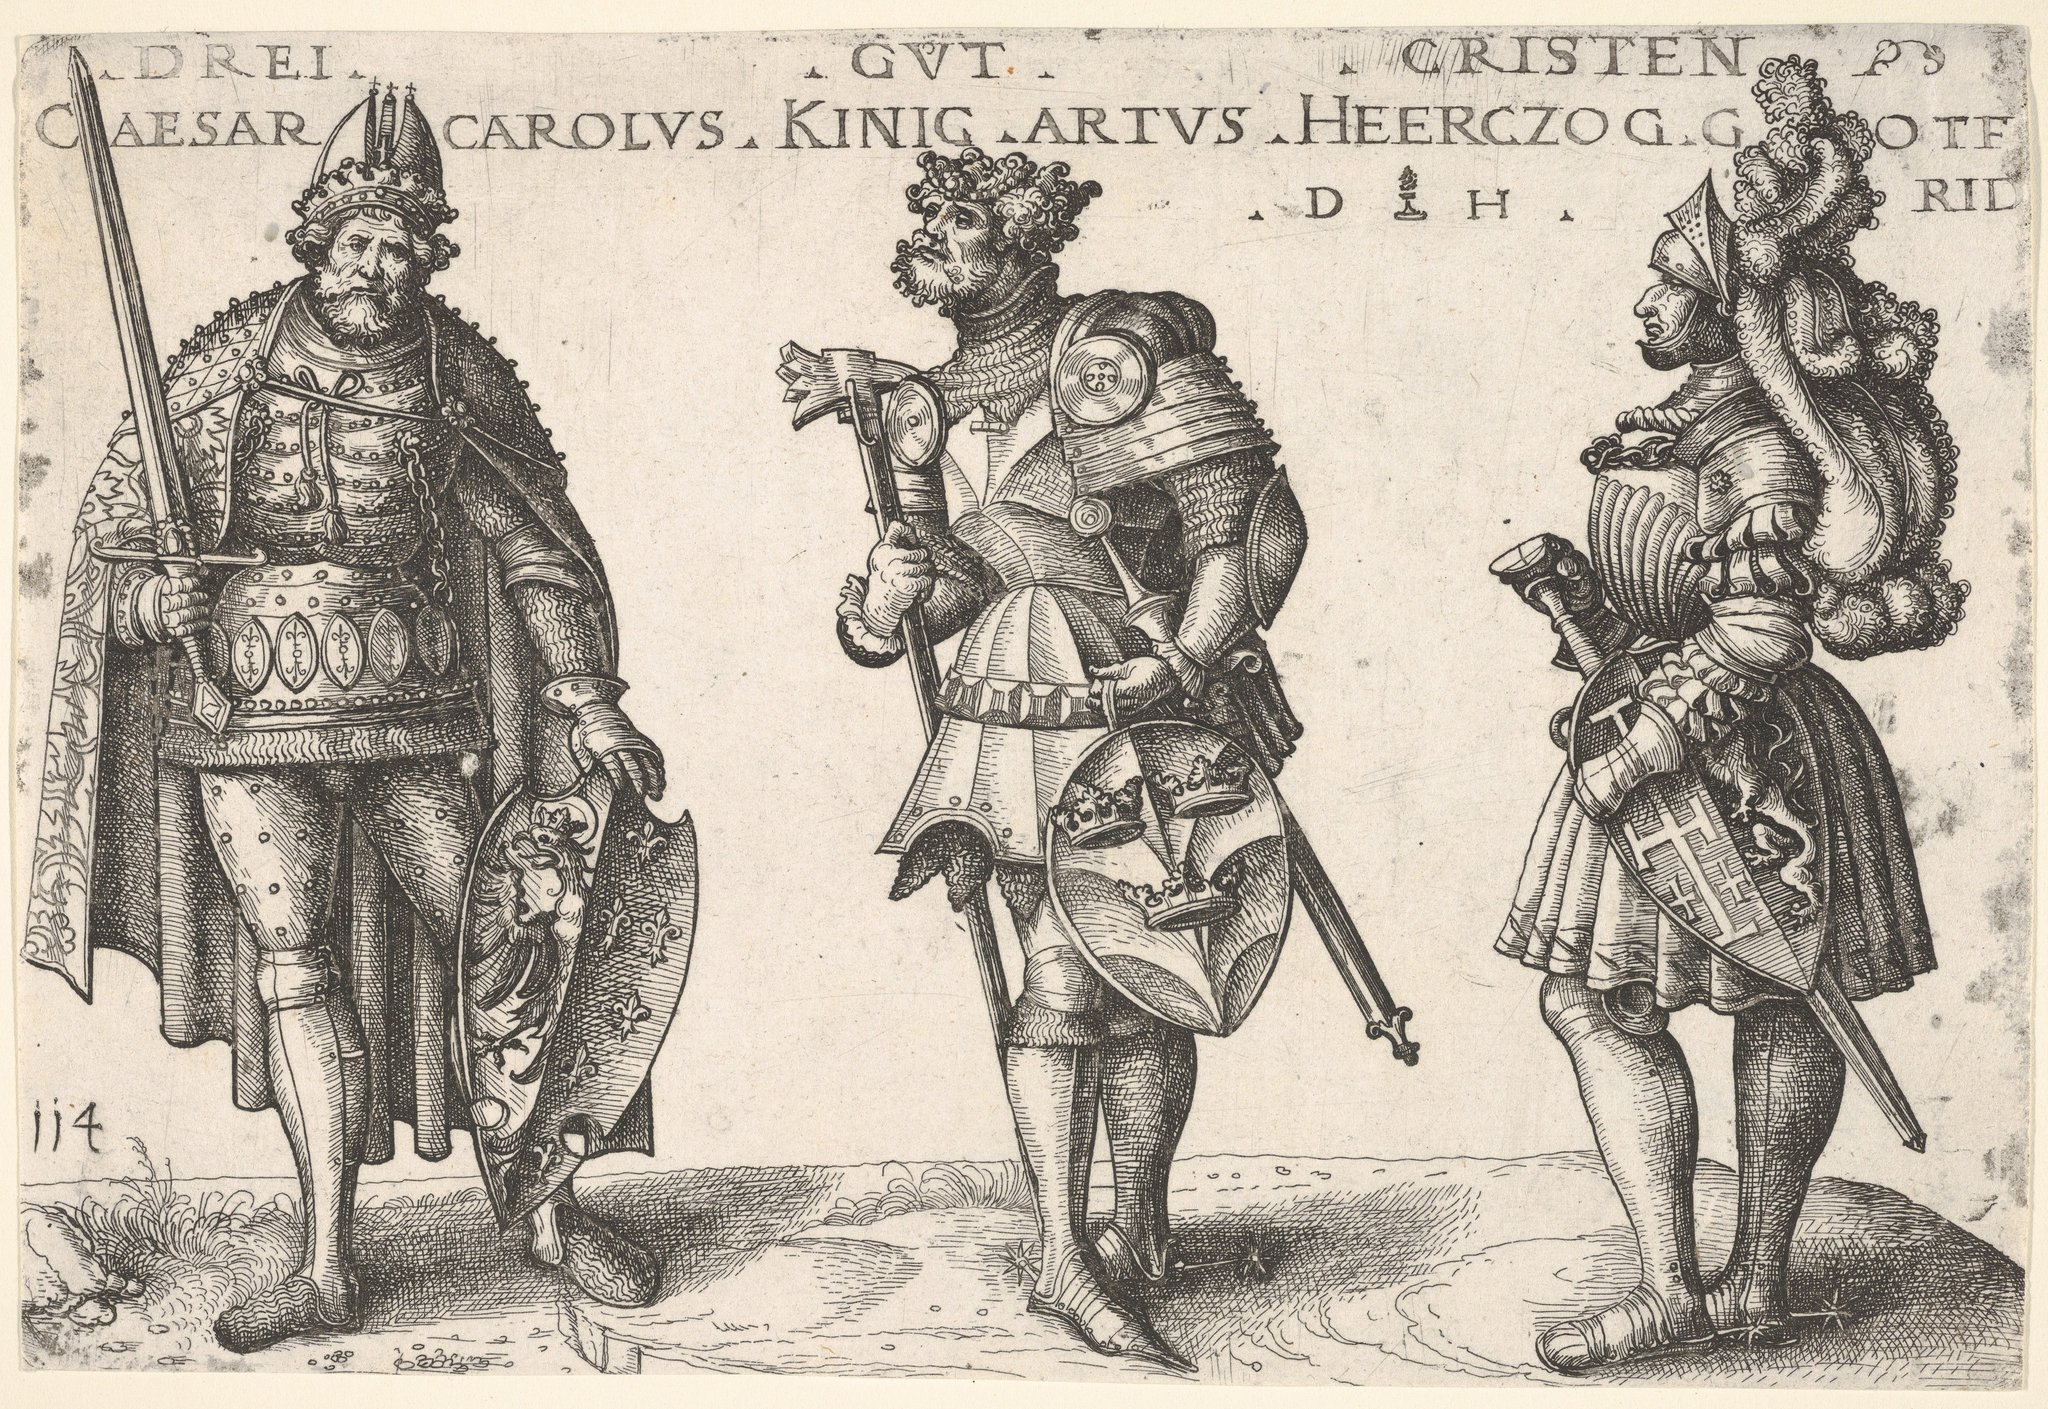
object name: print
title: Three Worthy Christians: Charlemagne, King Arthur, and Geoffrey of Bouillon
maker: daniel hopfer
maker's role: artist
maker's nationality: german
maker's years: 1470-1536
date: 1516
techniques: etching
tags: shields,swords,kings,knights